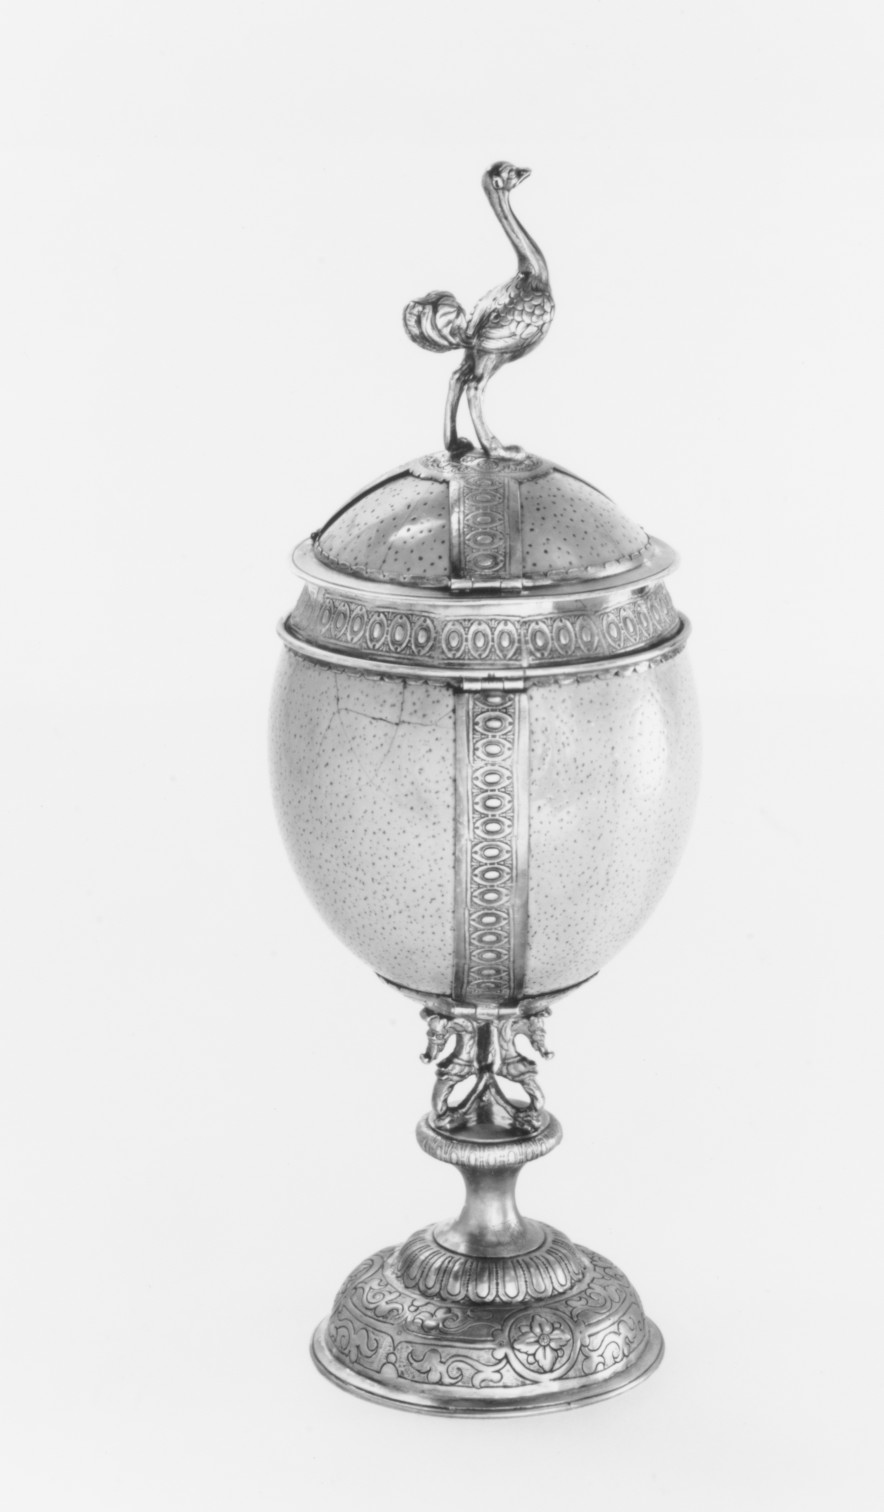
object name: cup with cover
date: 1591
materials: silver gilt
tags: birds